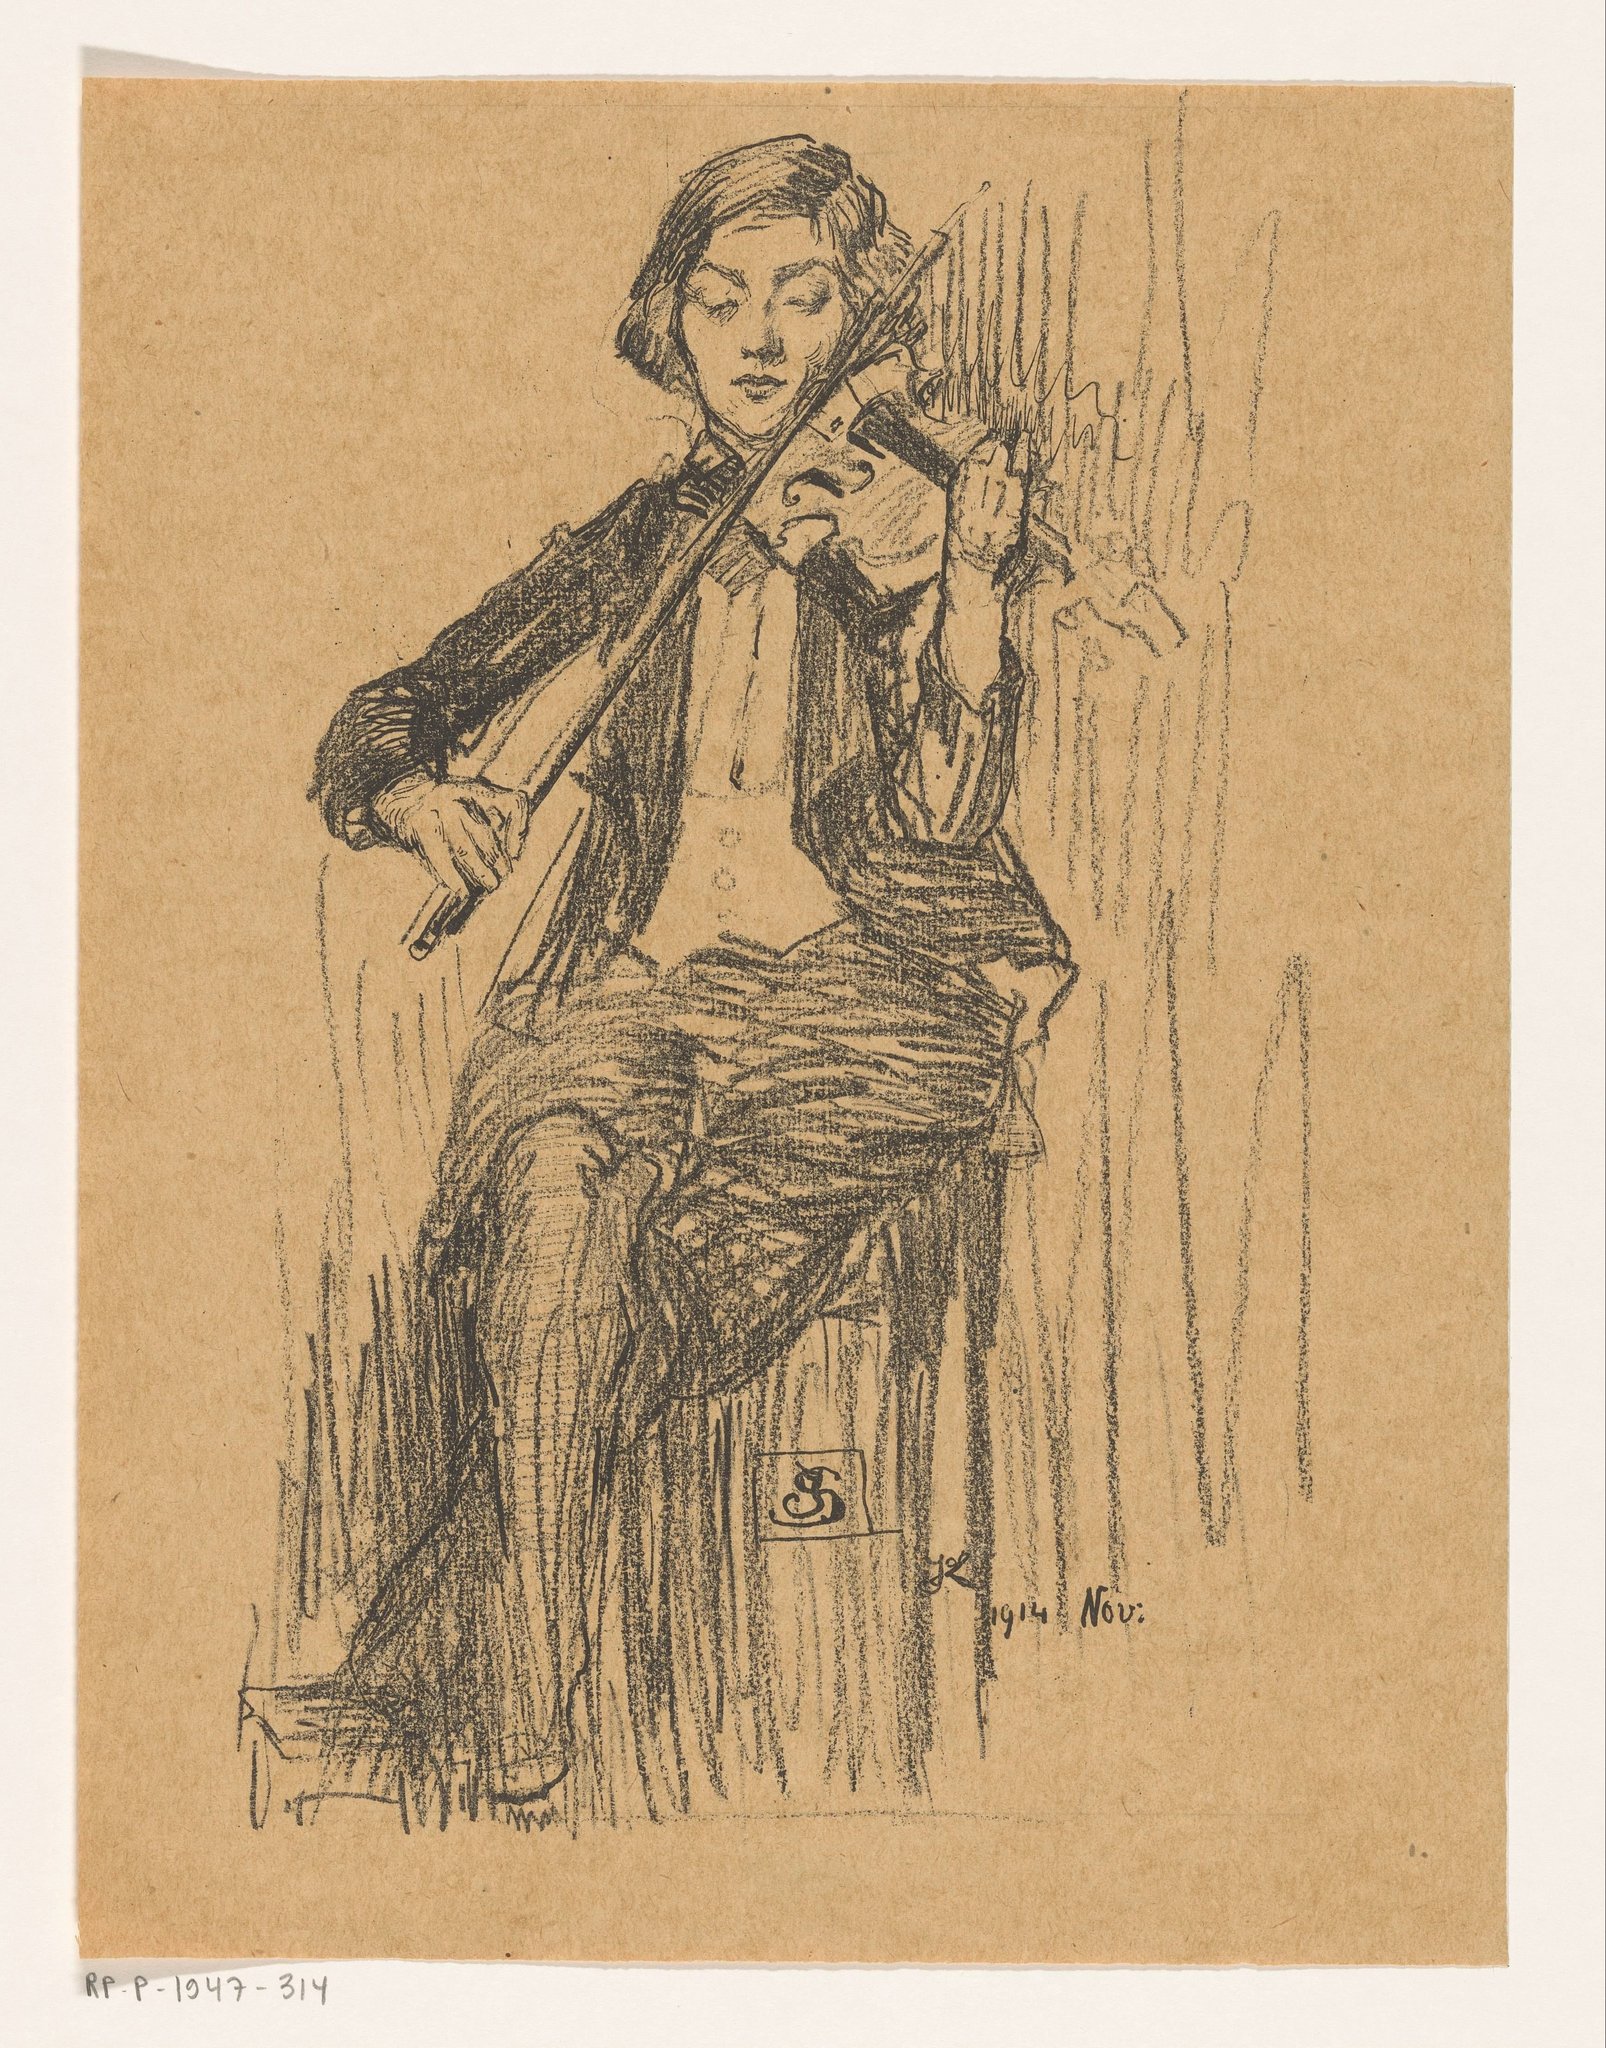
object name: print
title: Vioolspeler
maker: jo koster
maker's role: print maker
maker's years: 1869-1944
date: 1911-1914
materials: paper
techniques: lithograph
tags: one person playing string instrument (bowed), violin, fiddle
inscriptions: collector's mark: Lugt 2228